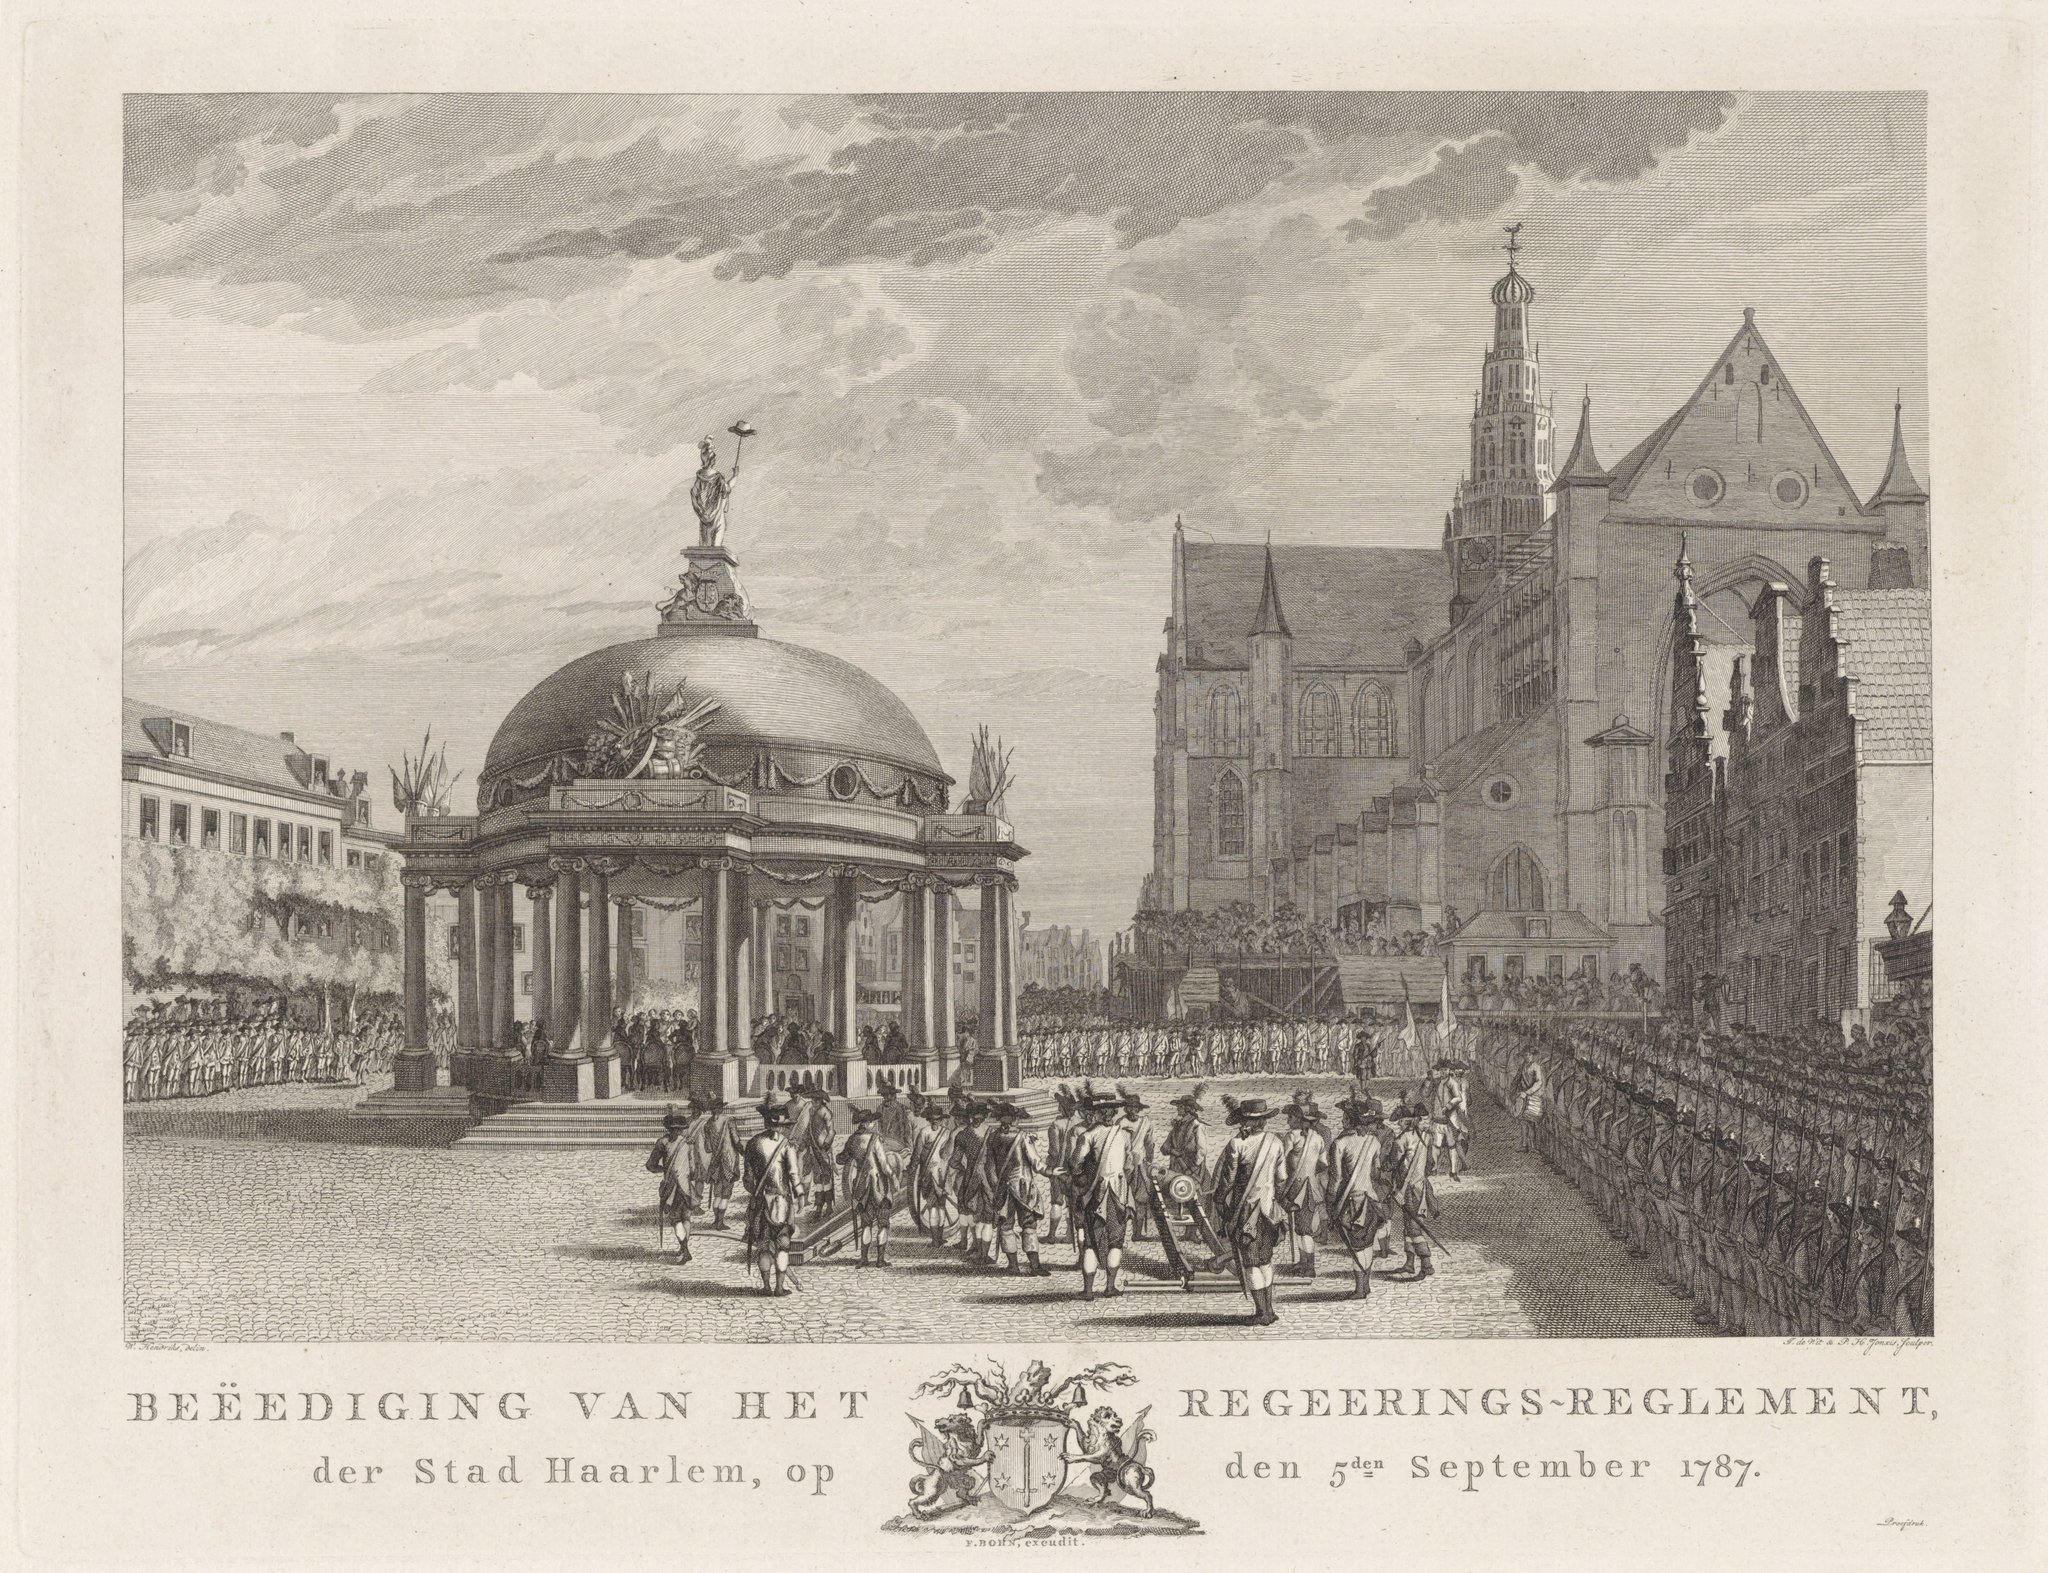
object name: print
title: Beëediging van het Regeerings-Reglement der stad Haarlem, op den 5den september 1787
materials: paper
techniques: engraving, etching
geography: northern netherlands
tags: proclamation of new government, warfare; military affairs (+ citizen soldiery, civil guard, citizen militia), patriots (1780-1795)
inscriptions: collector's mark: Lugt Lugt 2228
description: Plechtige ceremonie met de beëdiging van het nieuwe regeringsreglement in een tempel opgericht op de Grote Markt te Haarlem, 5 september 1787. Om het plein staan schutterijen opgesteld, bij de tempel enkele stukken geschut. In de marge het stadswapen van Haarlem.